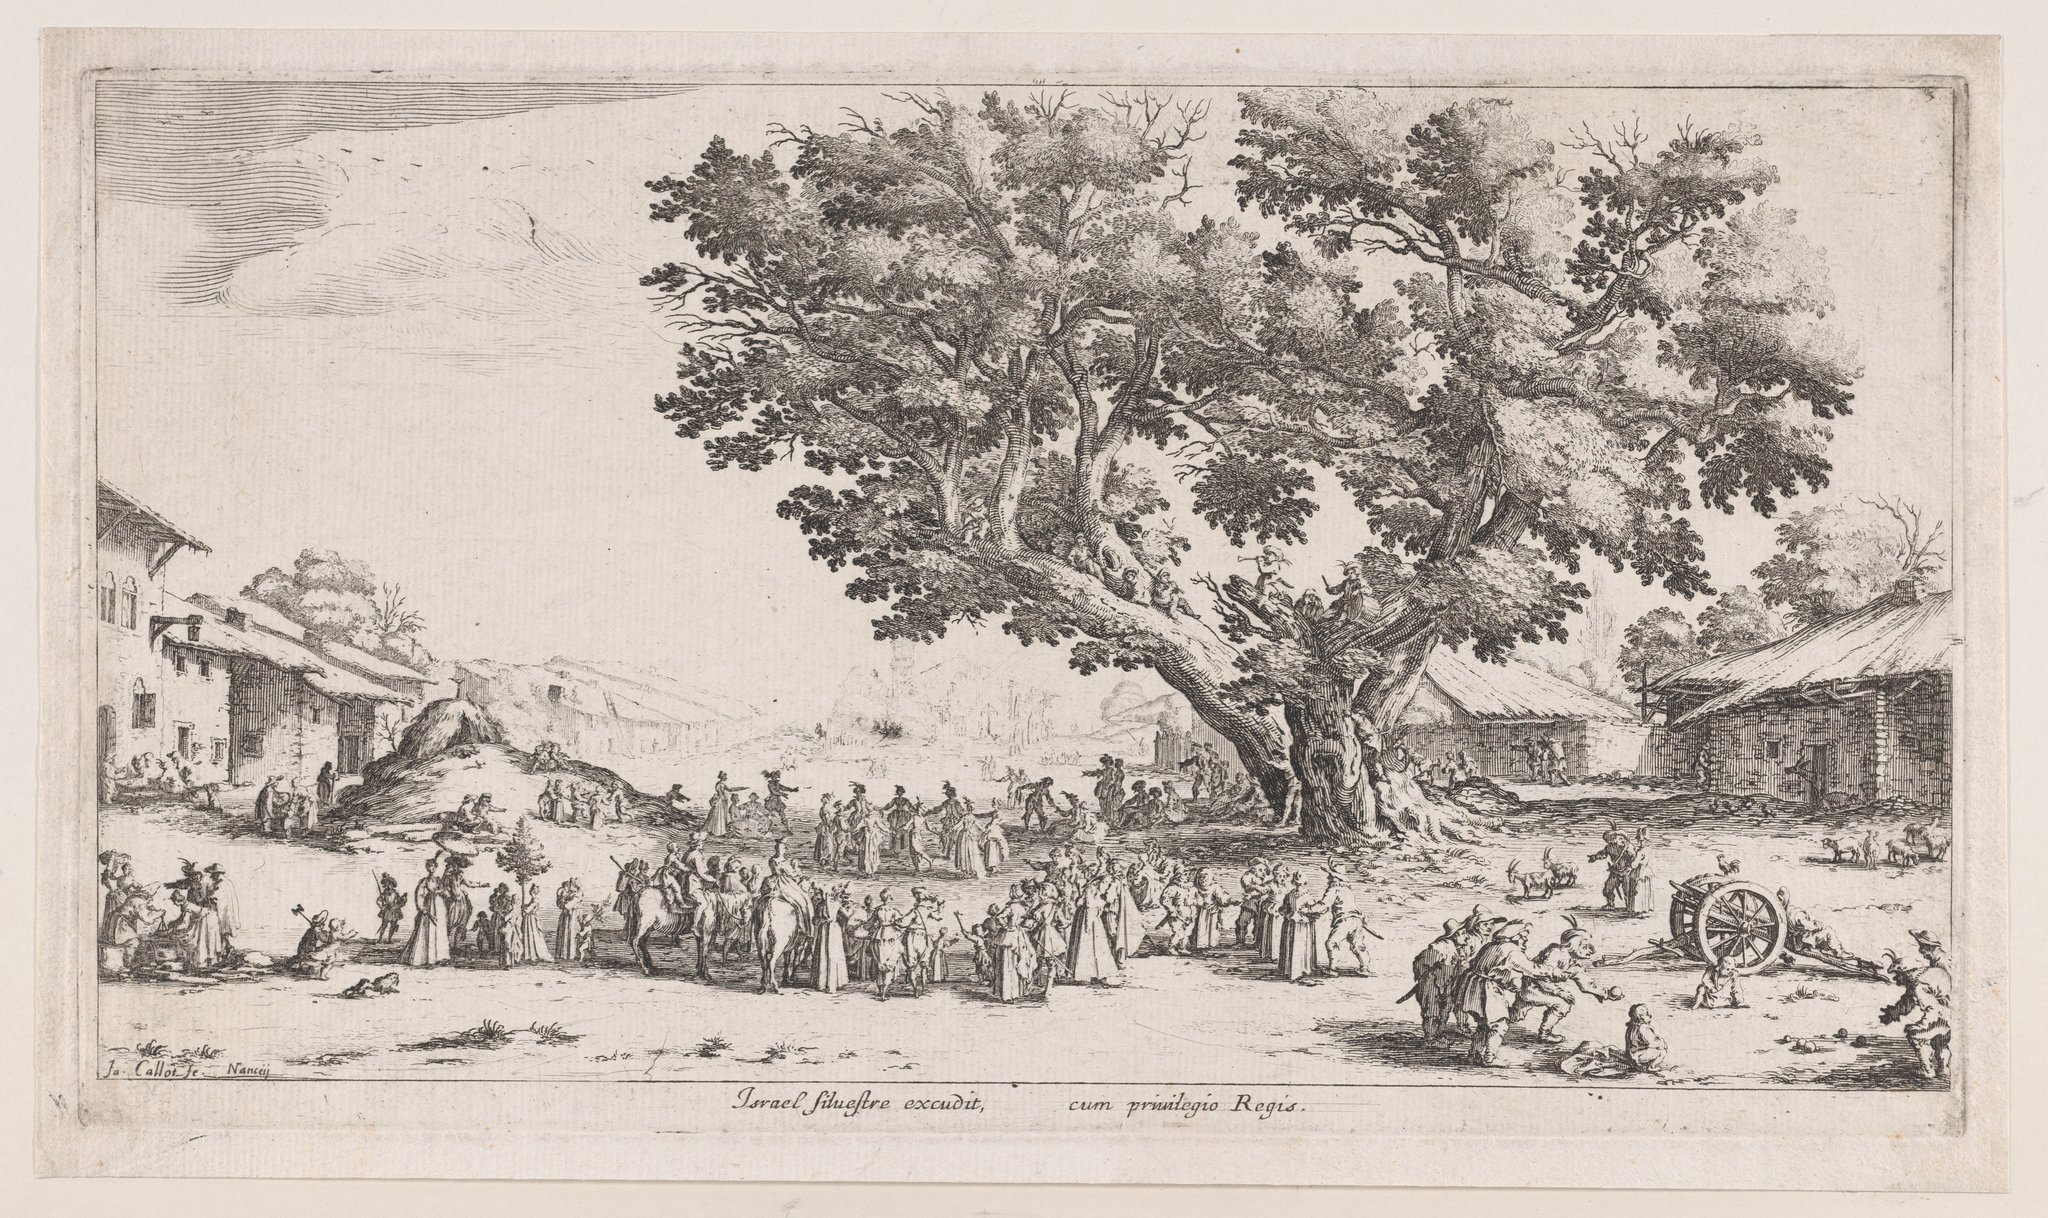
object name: print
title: La Fiore de Gondreville pièce appelée aussi La Fête du Village, La Petite Foire, Le Bal Champêtre, Le Jeu de Boules (The Fair at Gondreville also called The Village Festival, The Little Fair, The Country Dance, The Game of Bowls)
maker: jacques callot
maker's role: artist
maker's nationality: french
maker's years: 1592-1635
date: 1624-1625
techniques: etching